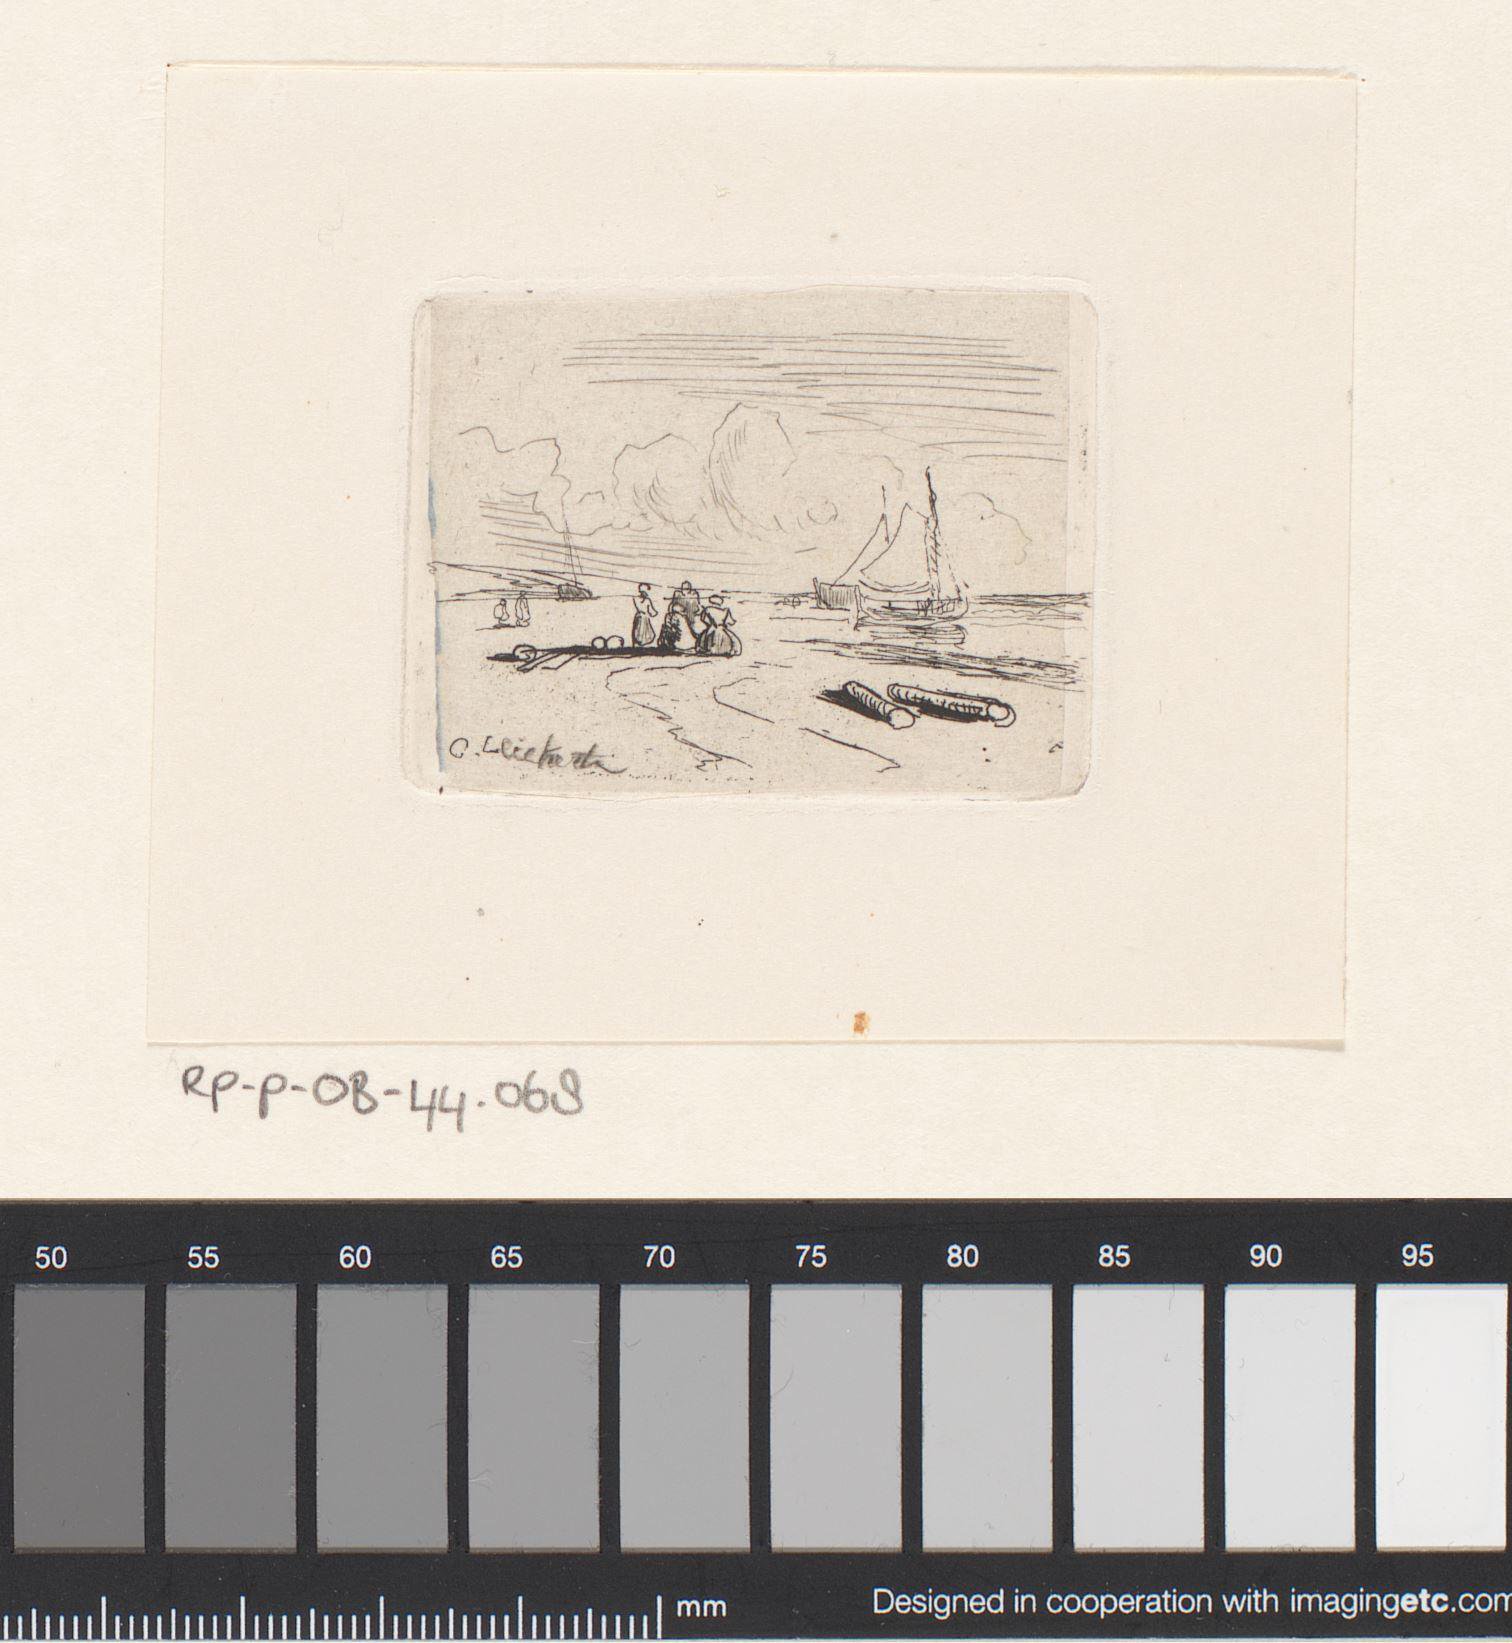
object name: print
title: Figuren op het strand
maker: charles leickert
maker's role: draughtsman, painter, print maker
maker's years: 1816-1907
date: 1826-1907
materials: paper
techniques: etching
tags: sailing-ship, sailing-boat, beach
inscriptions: collector's mark: Lugt 2228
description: Strandgezicht met wandelende figuren, in het water liggen twee zeilschepen.